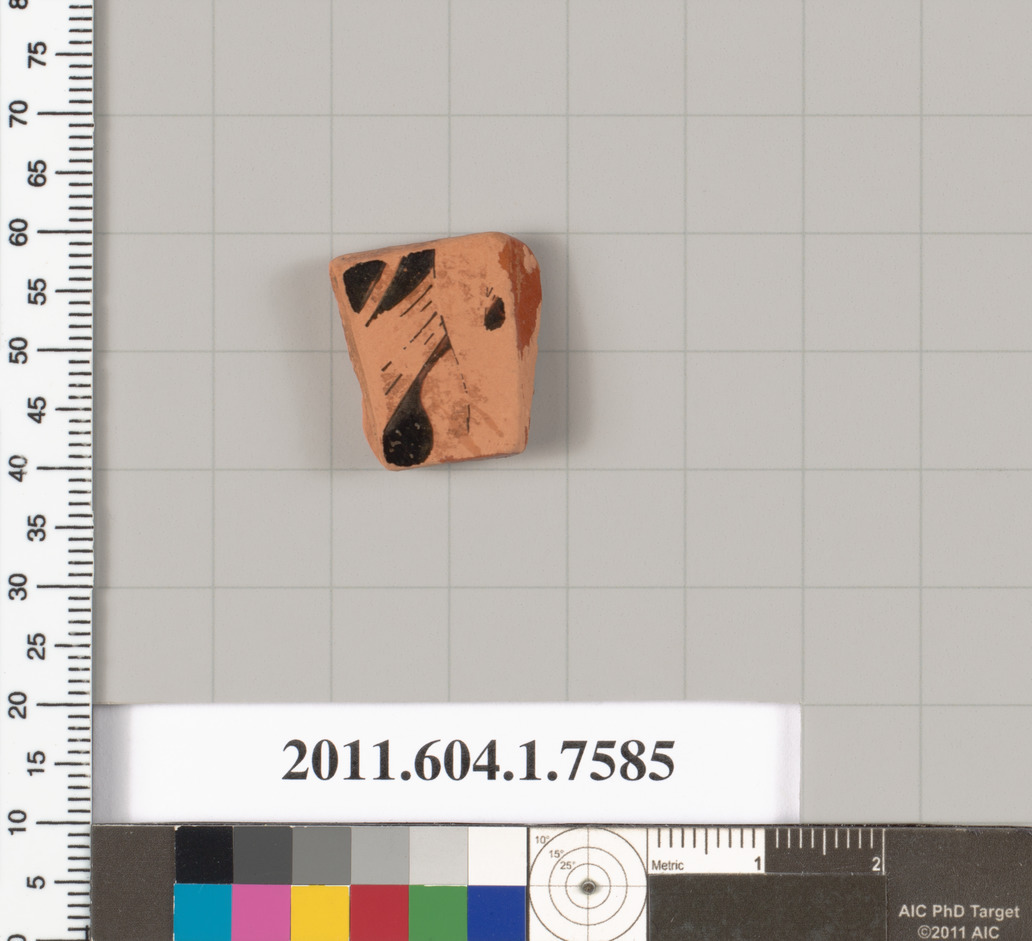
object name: kylix fragment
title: Terracotta fragment of a kylix (drinking cup)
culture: greek, attic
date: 460-450 BCE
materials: terracotta